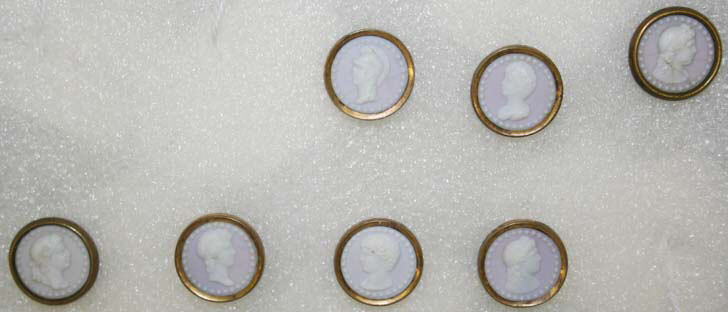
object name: button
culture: european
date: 1850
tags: cameos